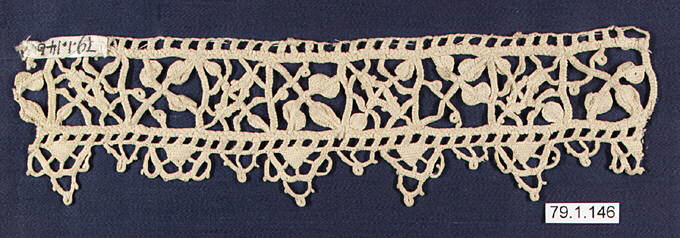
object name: fragment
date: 1501-1600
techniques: lace